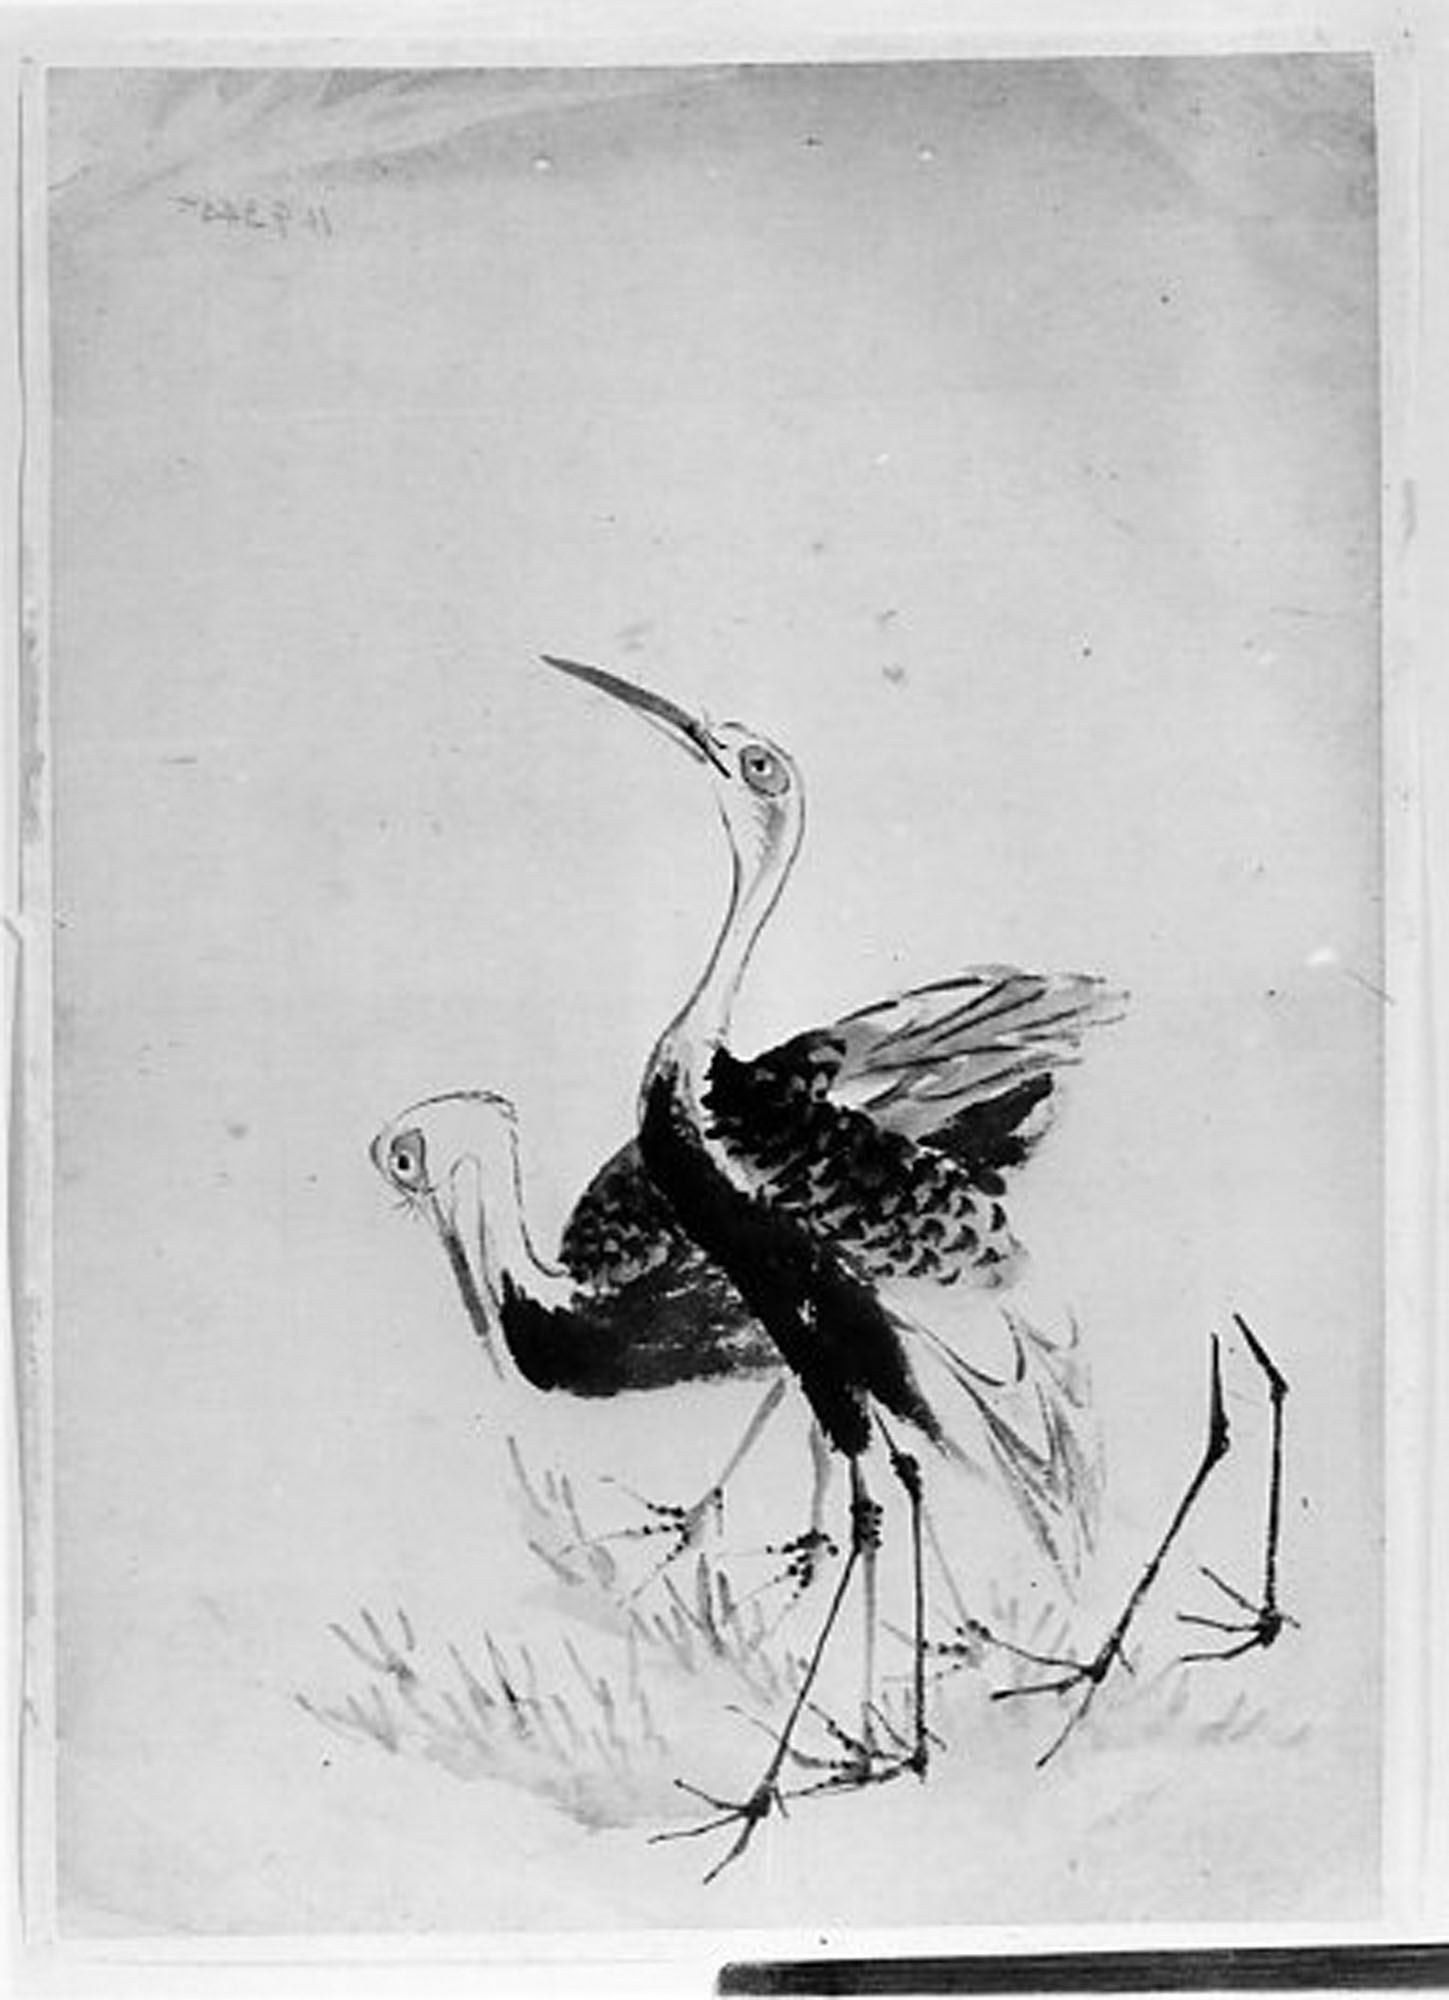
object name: painting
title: Two Cranes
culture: japanese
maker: hokusai school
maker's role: artist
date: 1801-1900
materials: ink, paper, watercolor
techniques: painting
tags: cranes